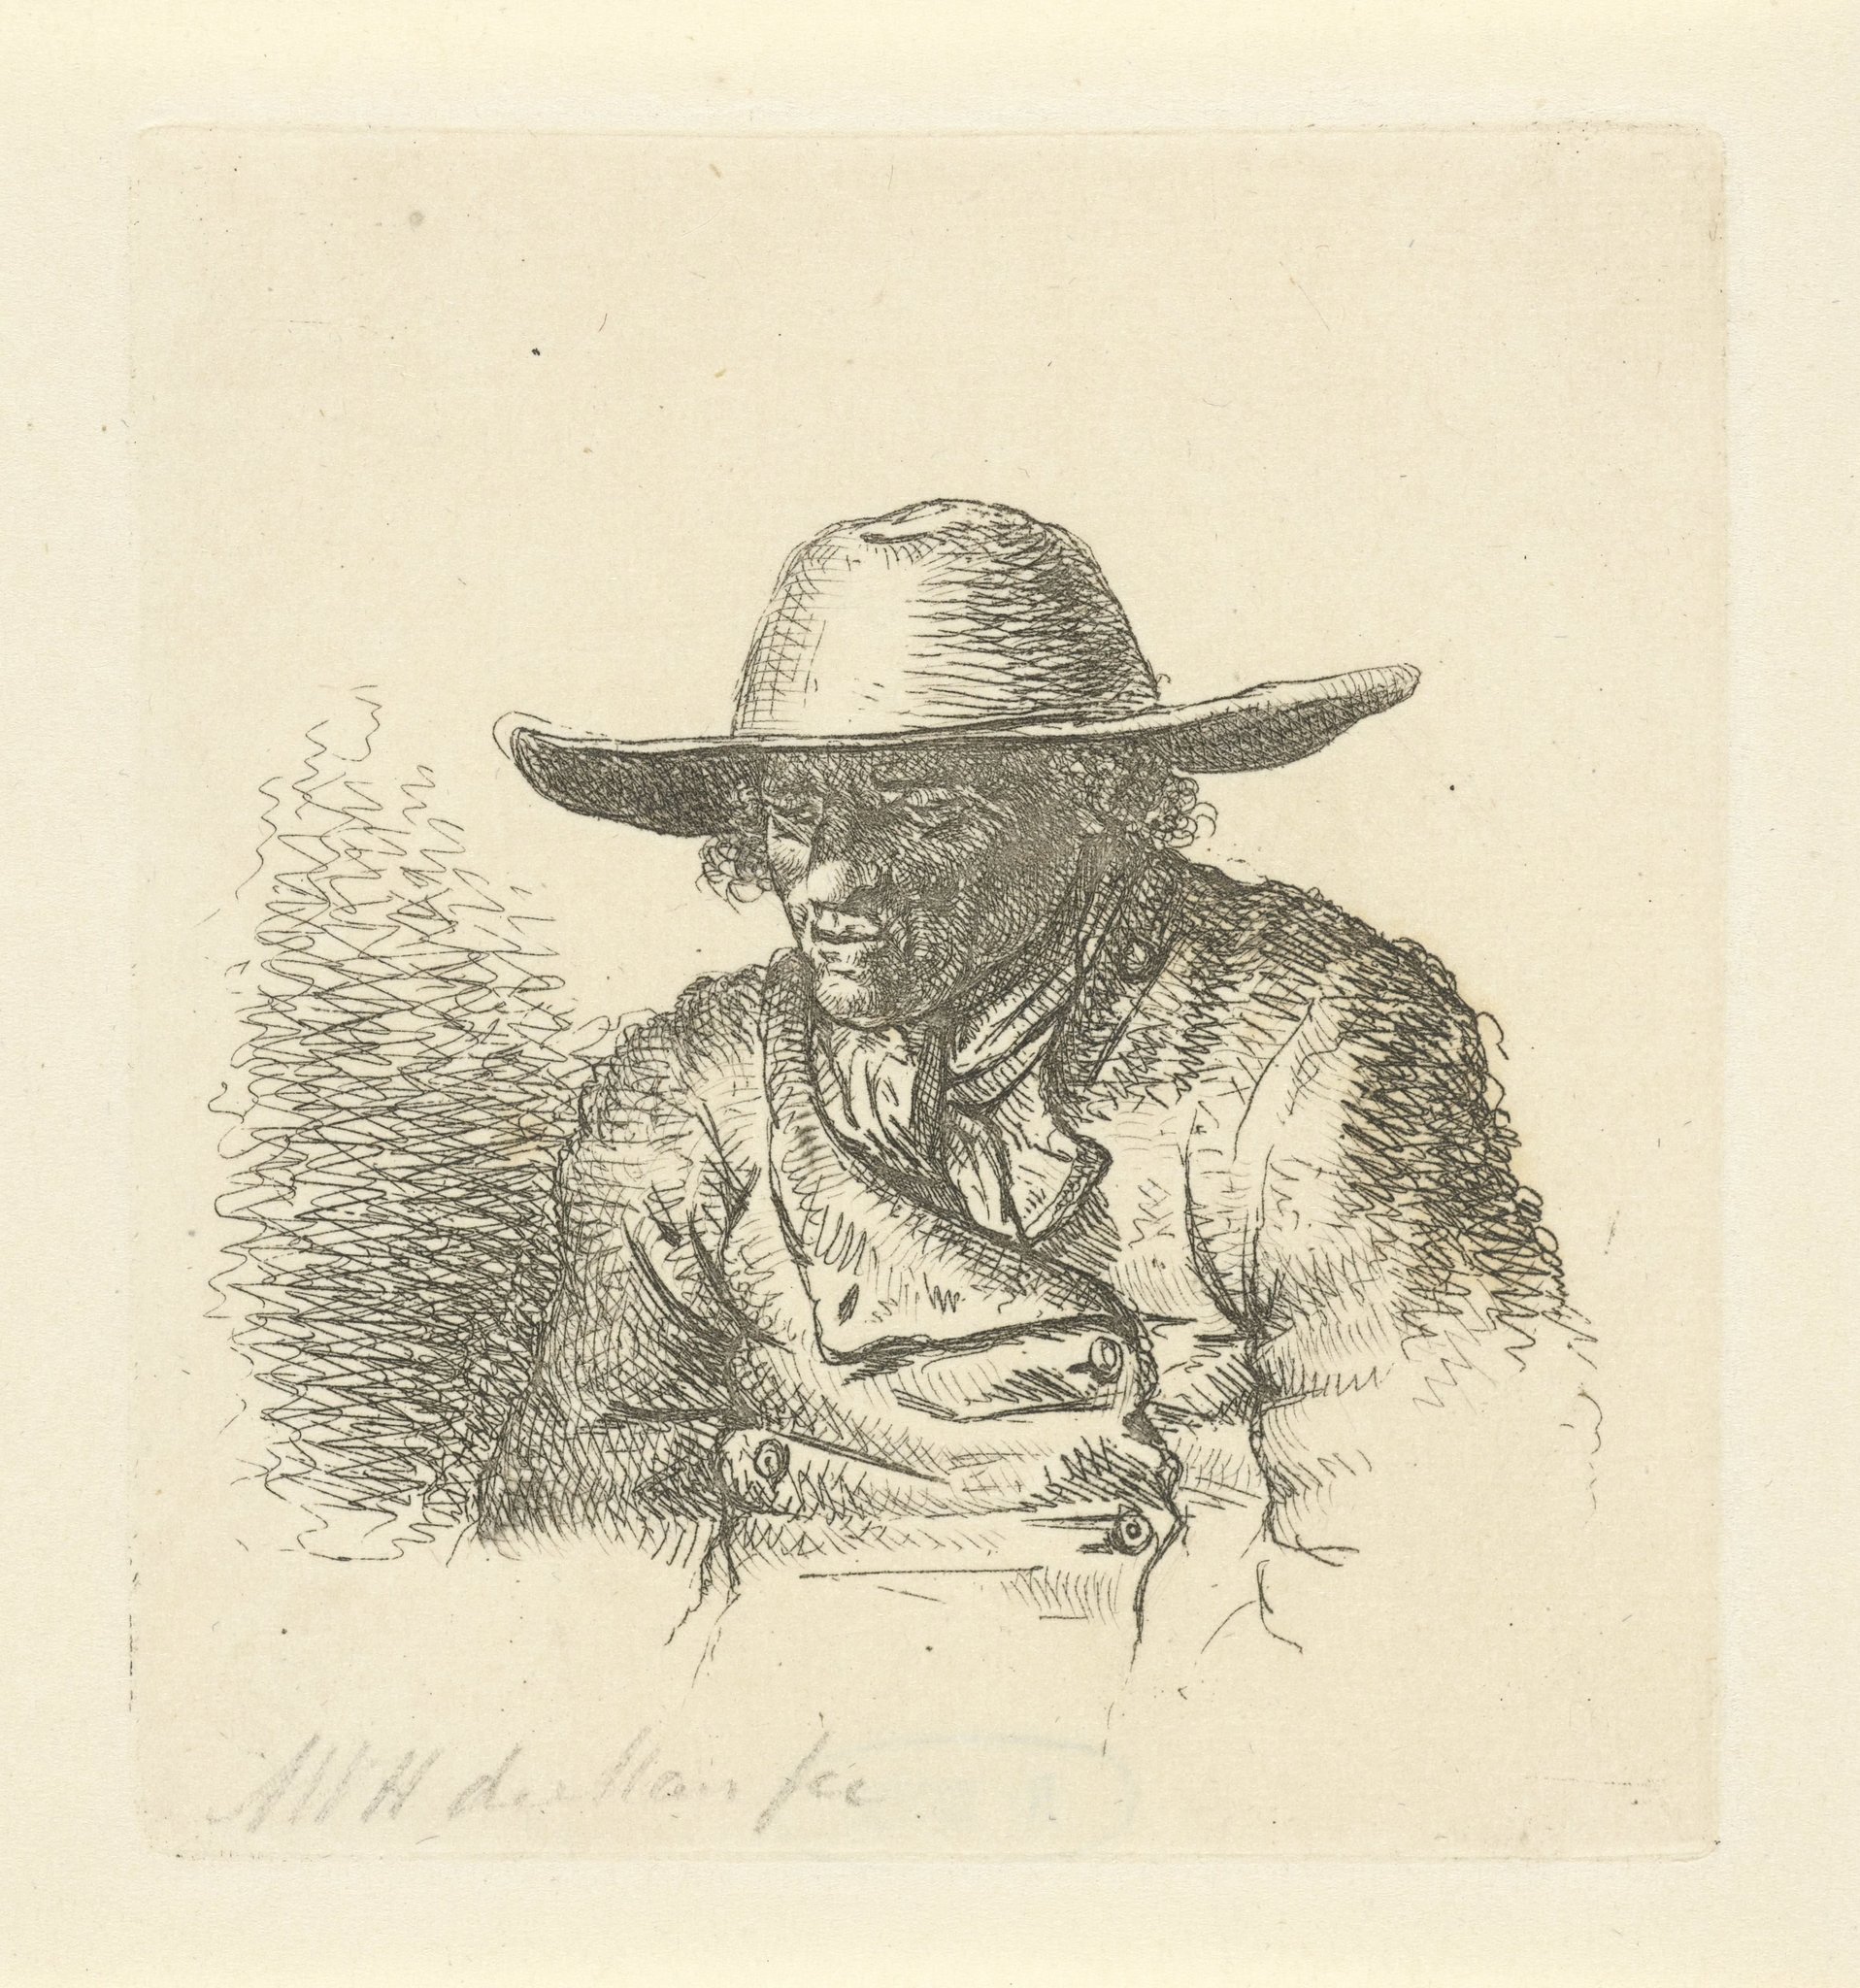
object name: print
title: Man met hoed met brede rand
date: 1803-1842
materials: paper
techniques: etching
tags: head-gear: hat (+ men's clothes)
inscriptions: collector's mark: Lugt 2228